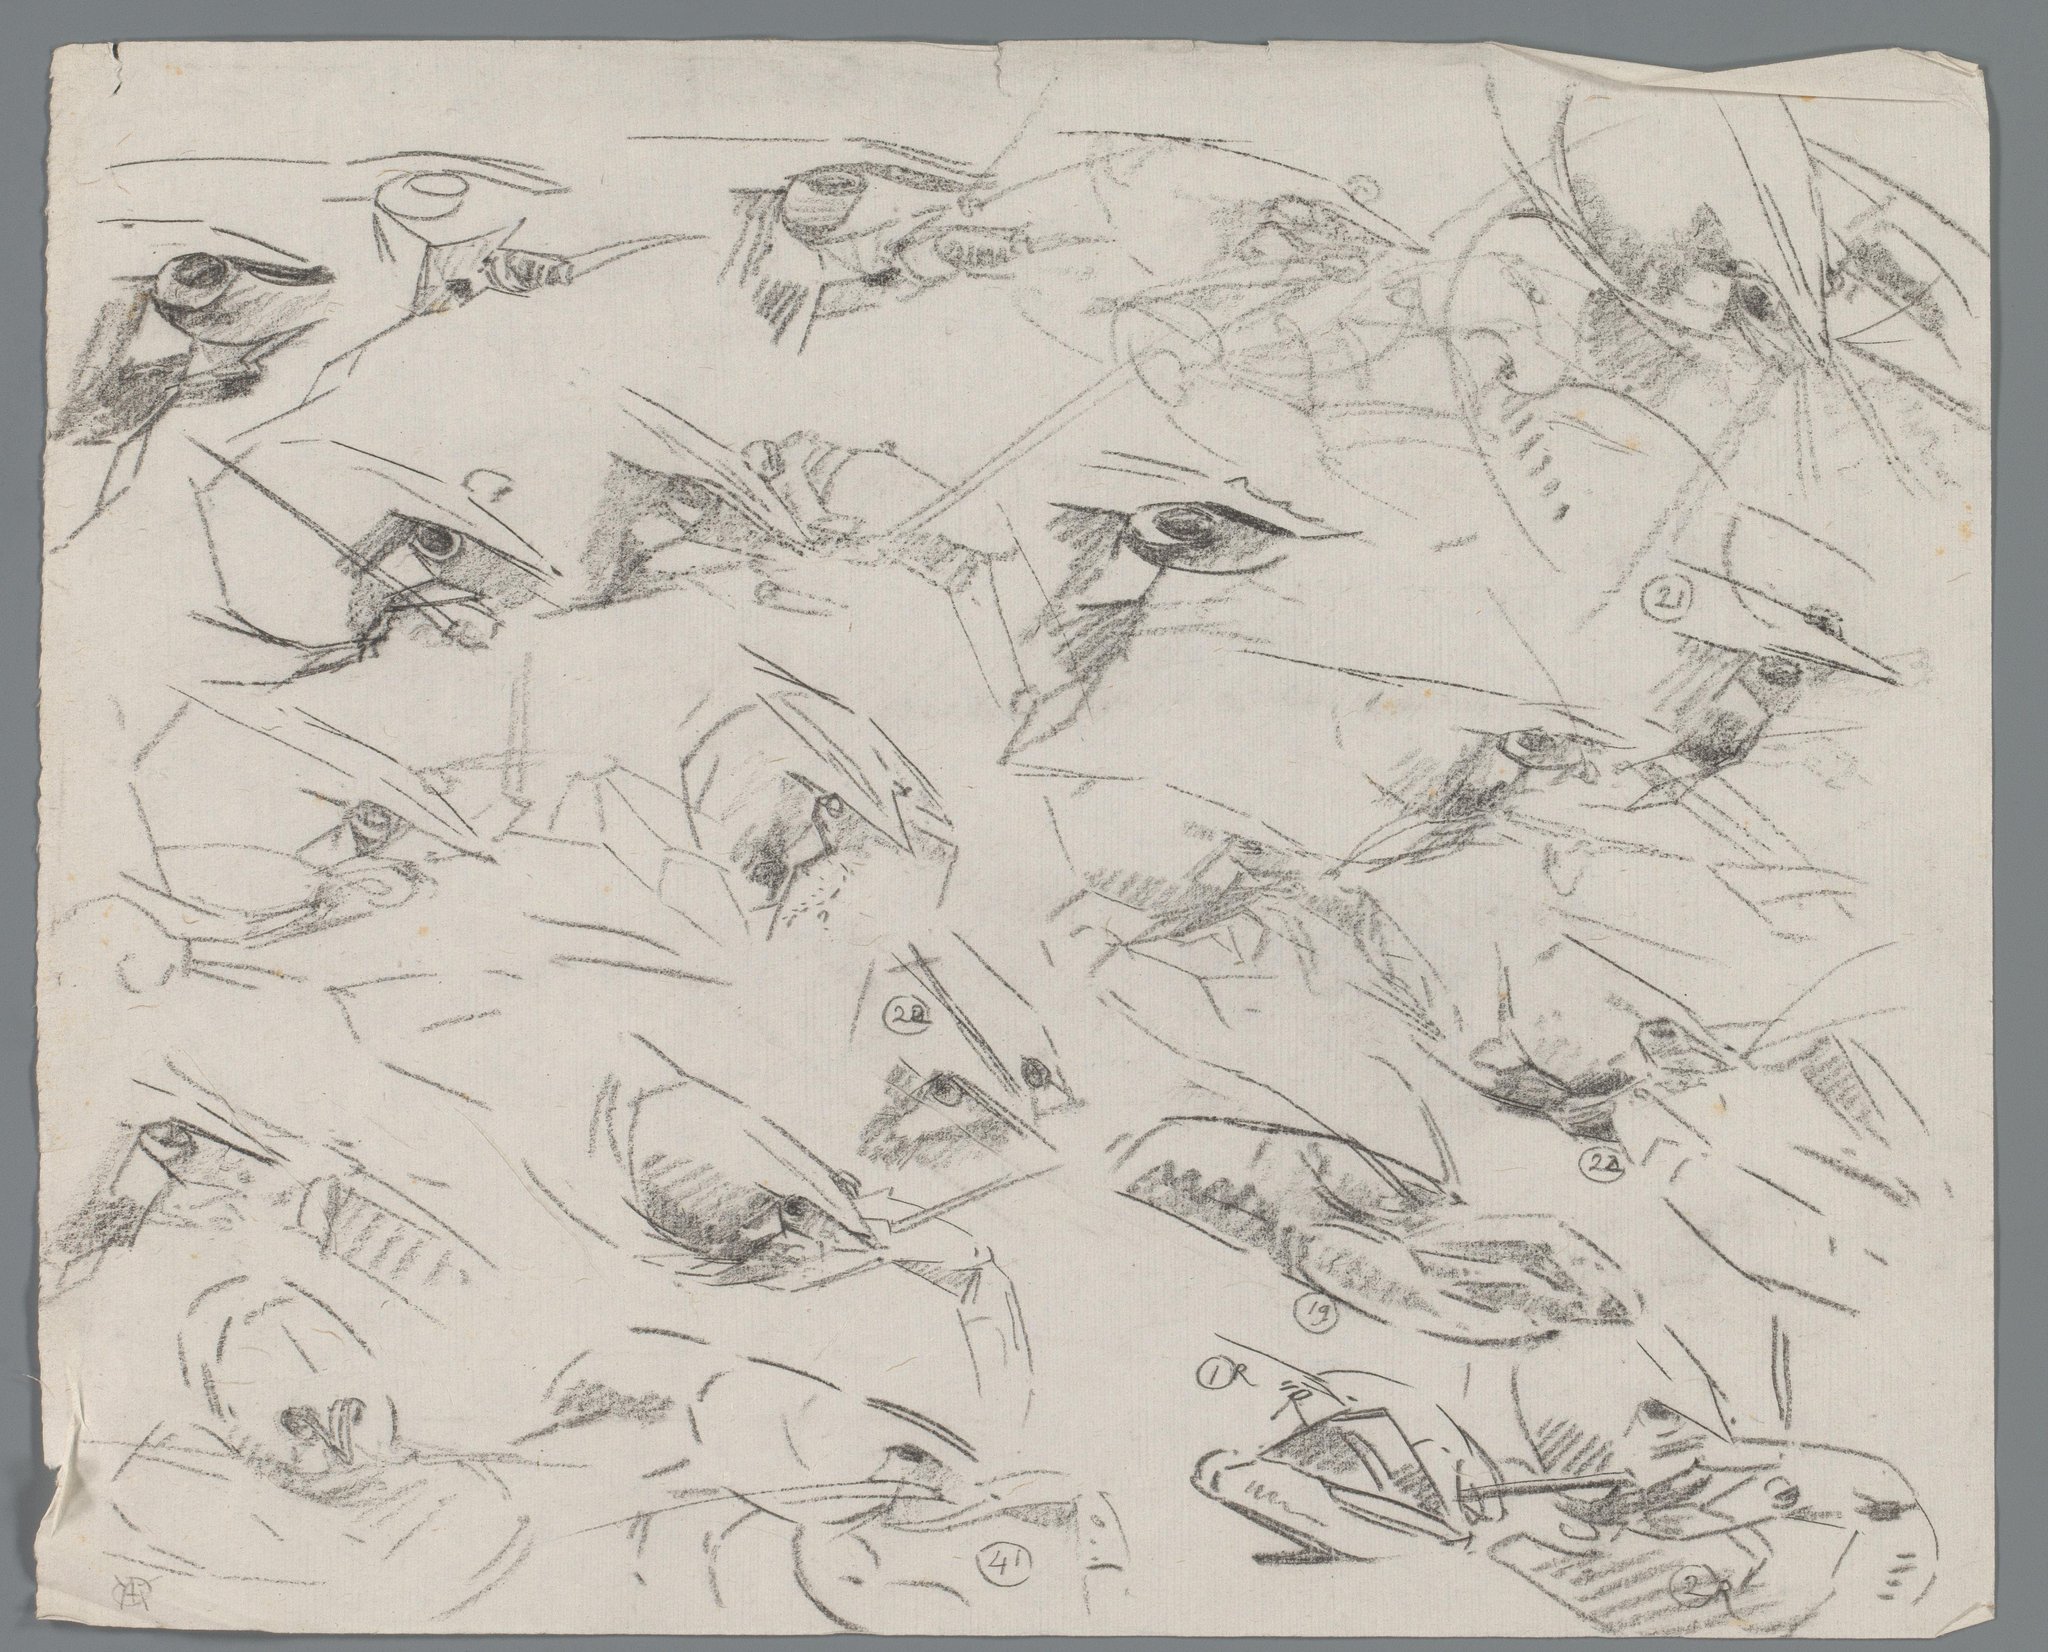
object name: drawing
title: Studieblad met kreeften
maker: gerrit willem dijsselhof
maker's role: designer, draughtsman, print maker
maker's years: 1866-1924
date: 1876-1924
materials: chalk, paper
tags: crustaceans: lobster